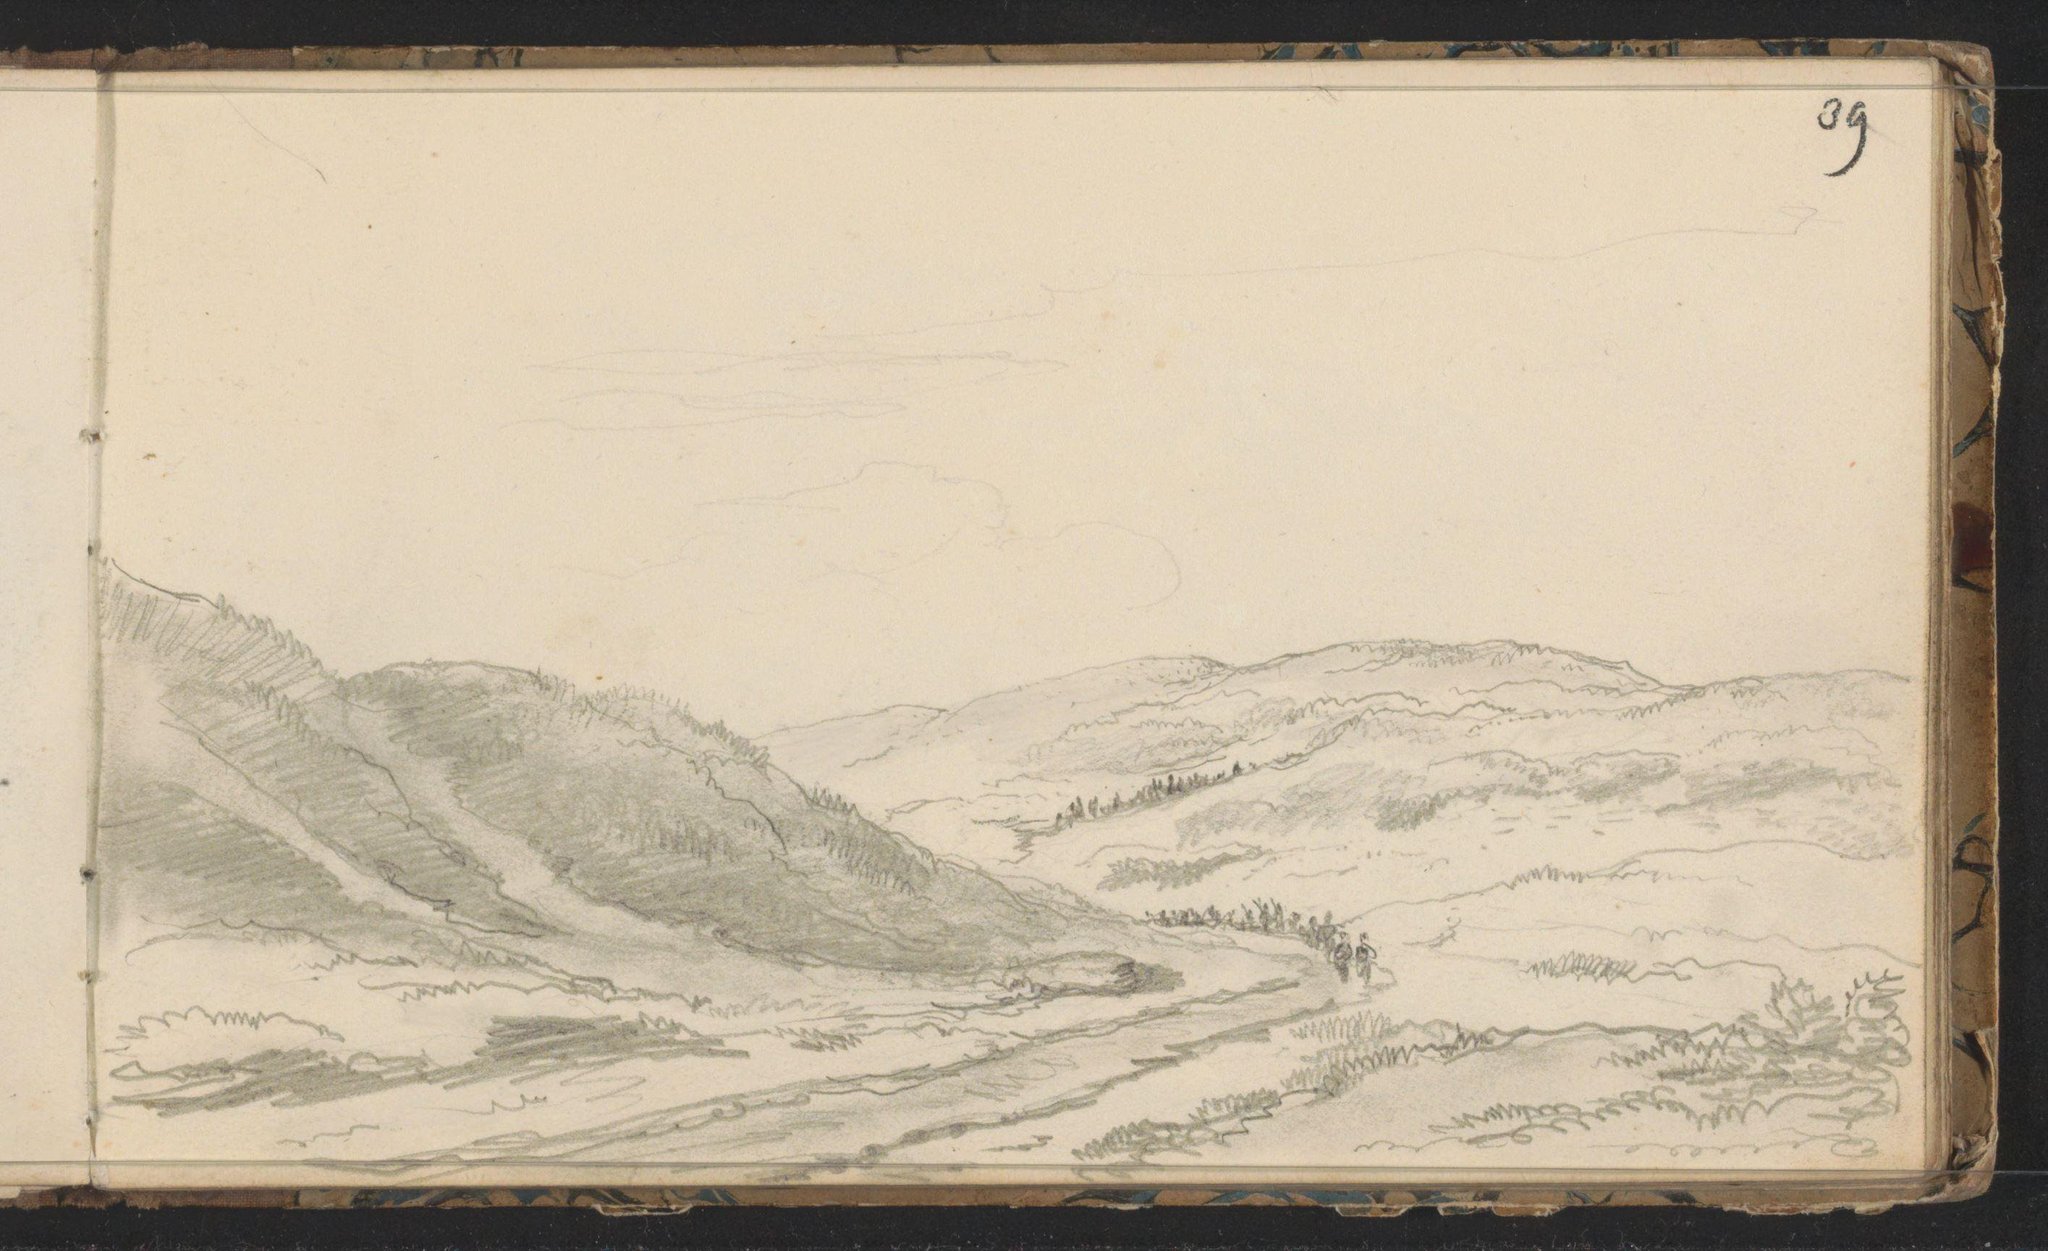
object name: sketchbook leaf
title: Pad in een heuvellandschap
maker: arnoldus johannes eymer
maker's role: draughtsman, print maker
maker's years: 1803-1863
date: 1803-1818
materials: paper, pencil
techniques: stumping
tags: low hill country (+ landscape with figures, staffage), road, path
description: Bladzijde 39 uit een schetsboek met 74 bladzijden.